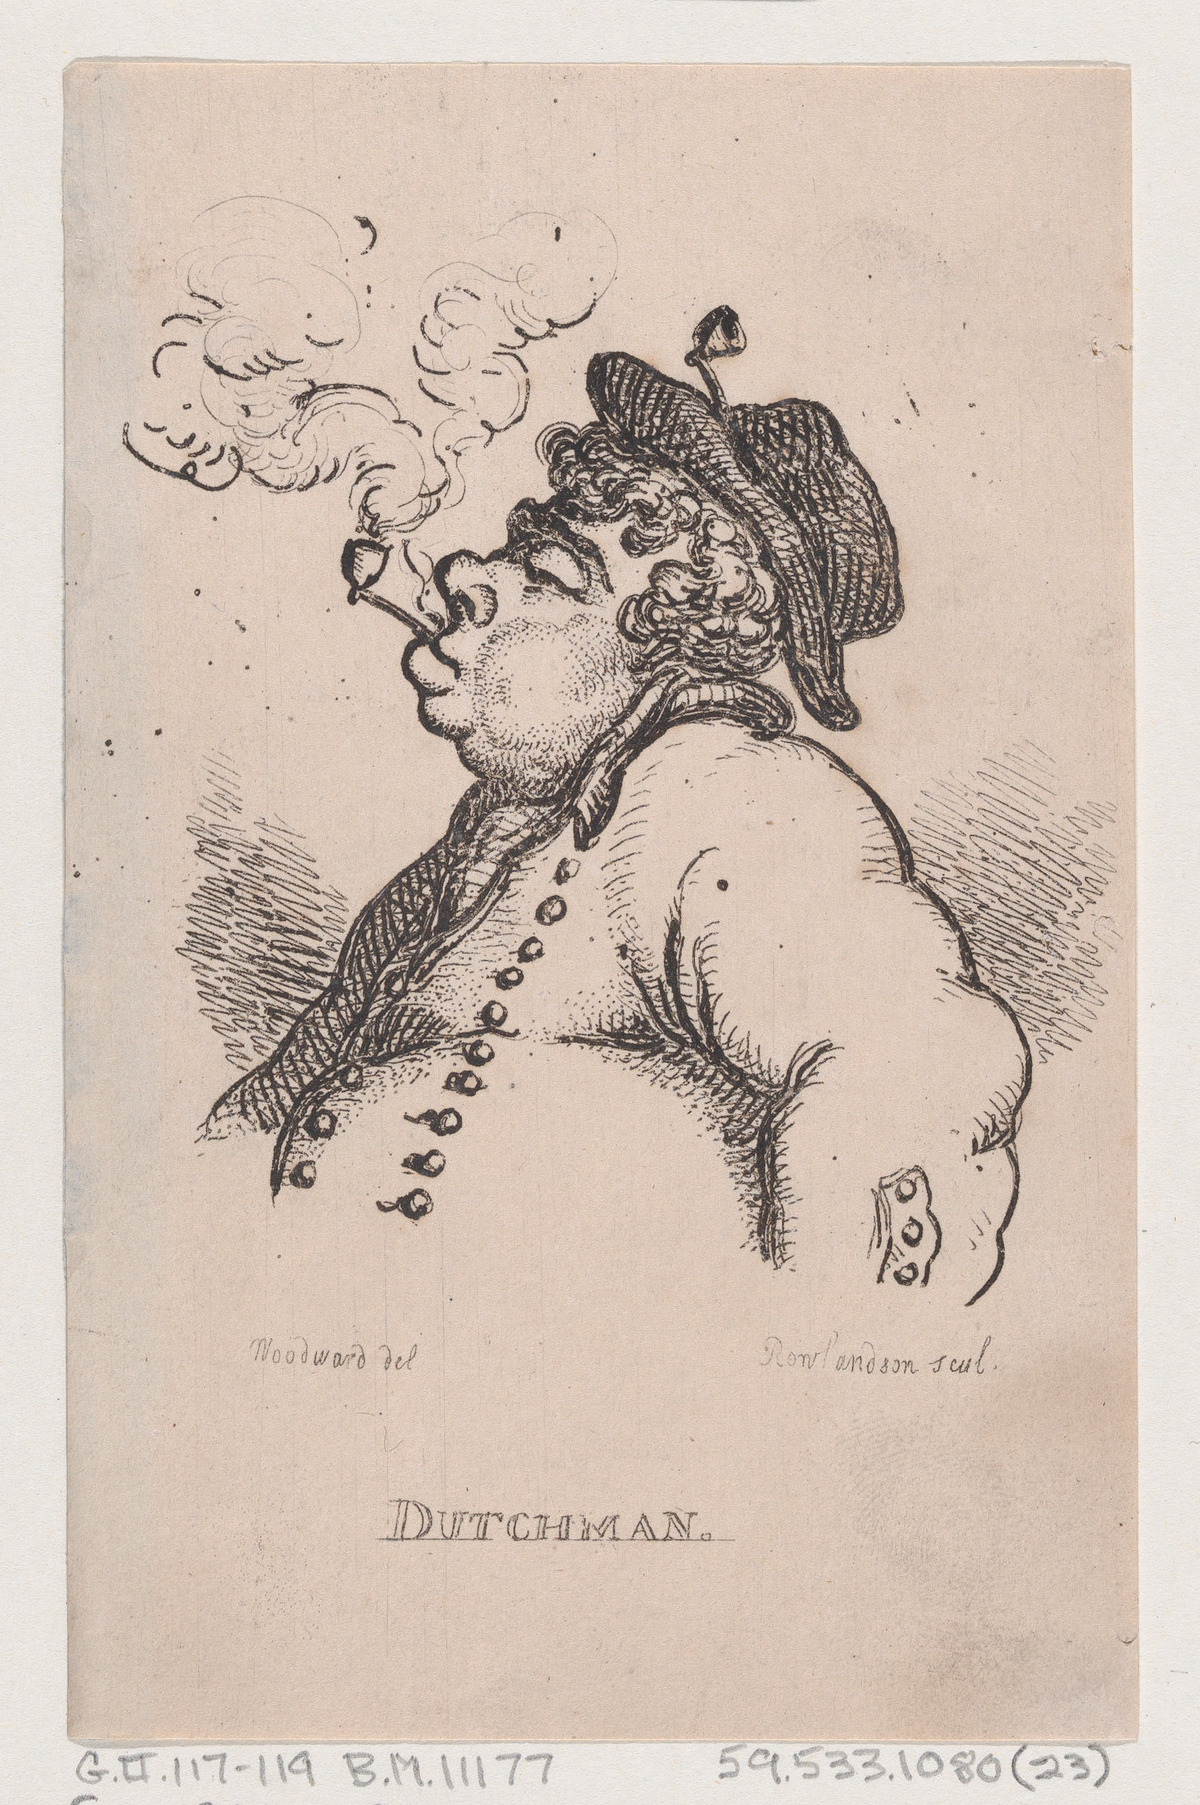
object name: print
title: Dutchman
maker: thomas rowlandson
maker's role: artist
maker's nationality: british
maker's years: 1757-1827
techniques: etching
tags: men,profiles,smoking